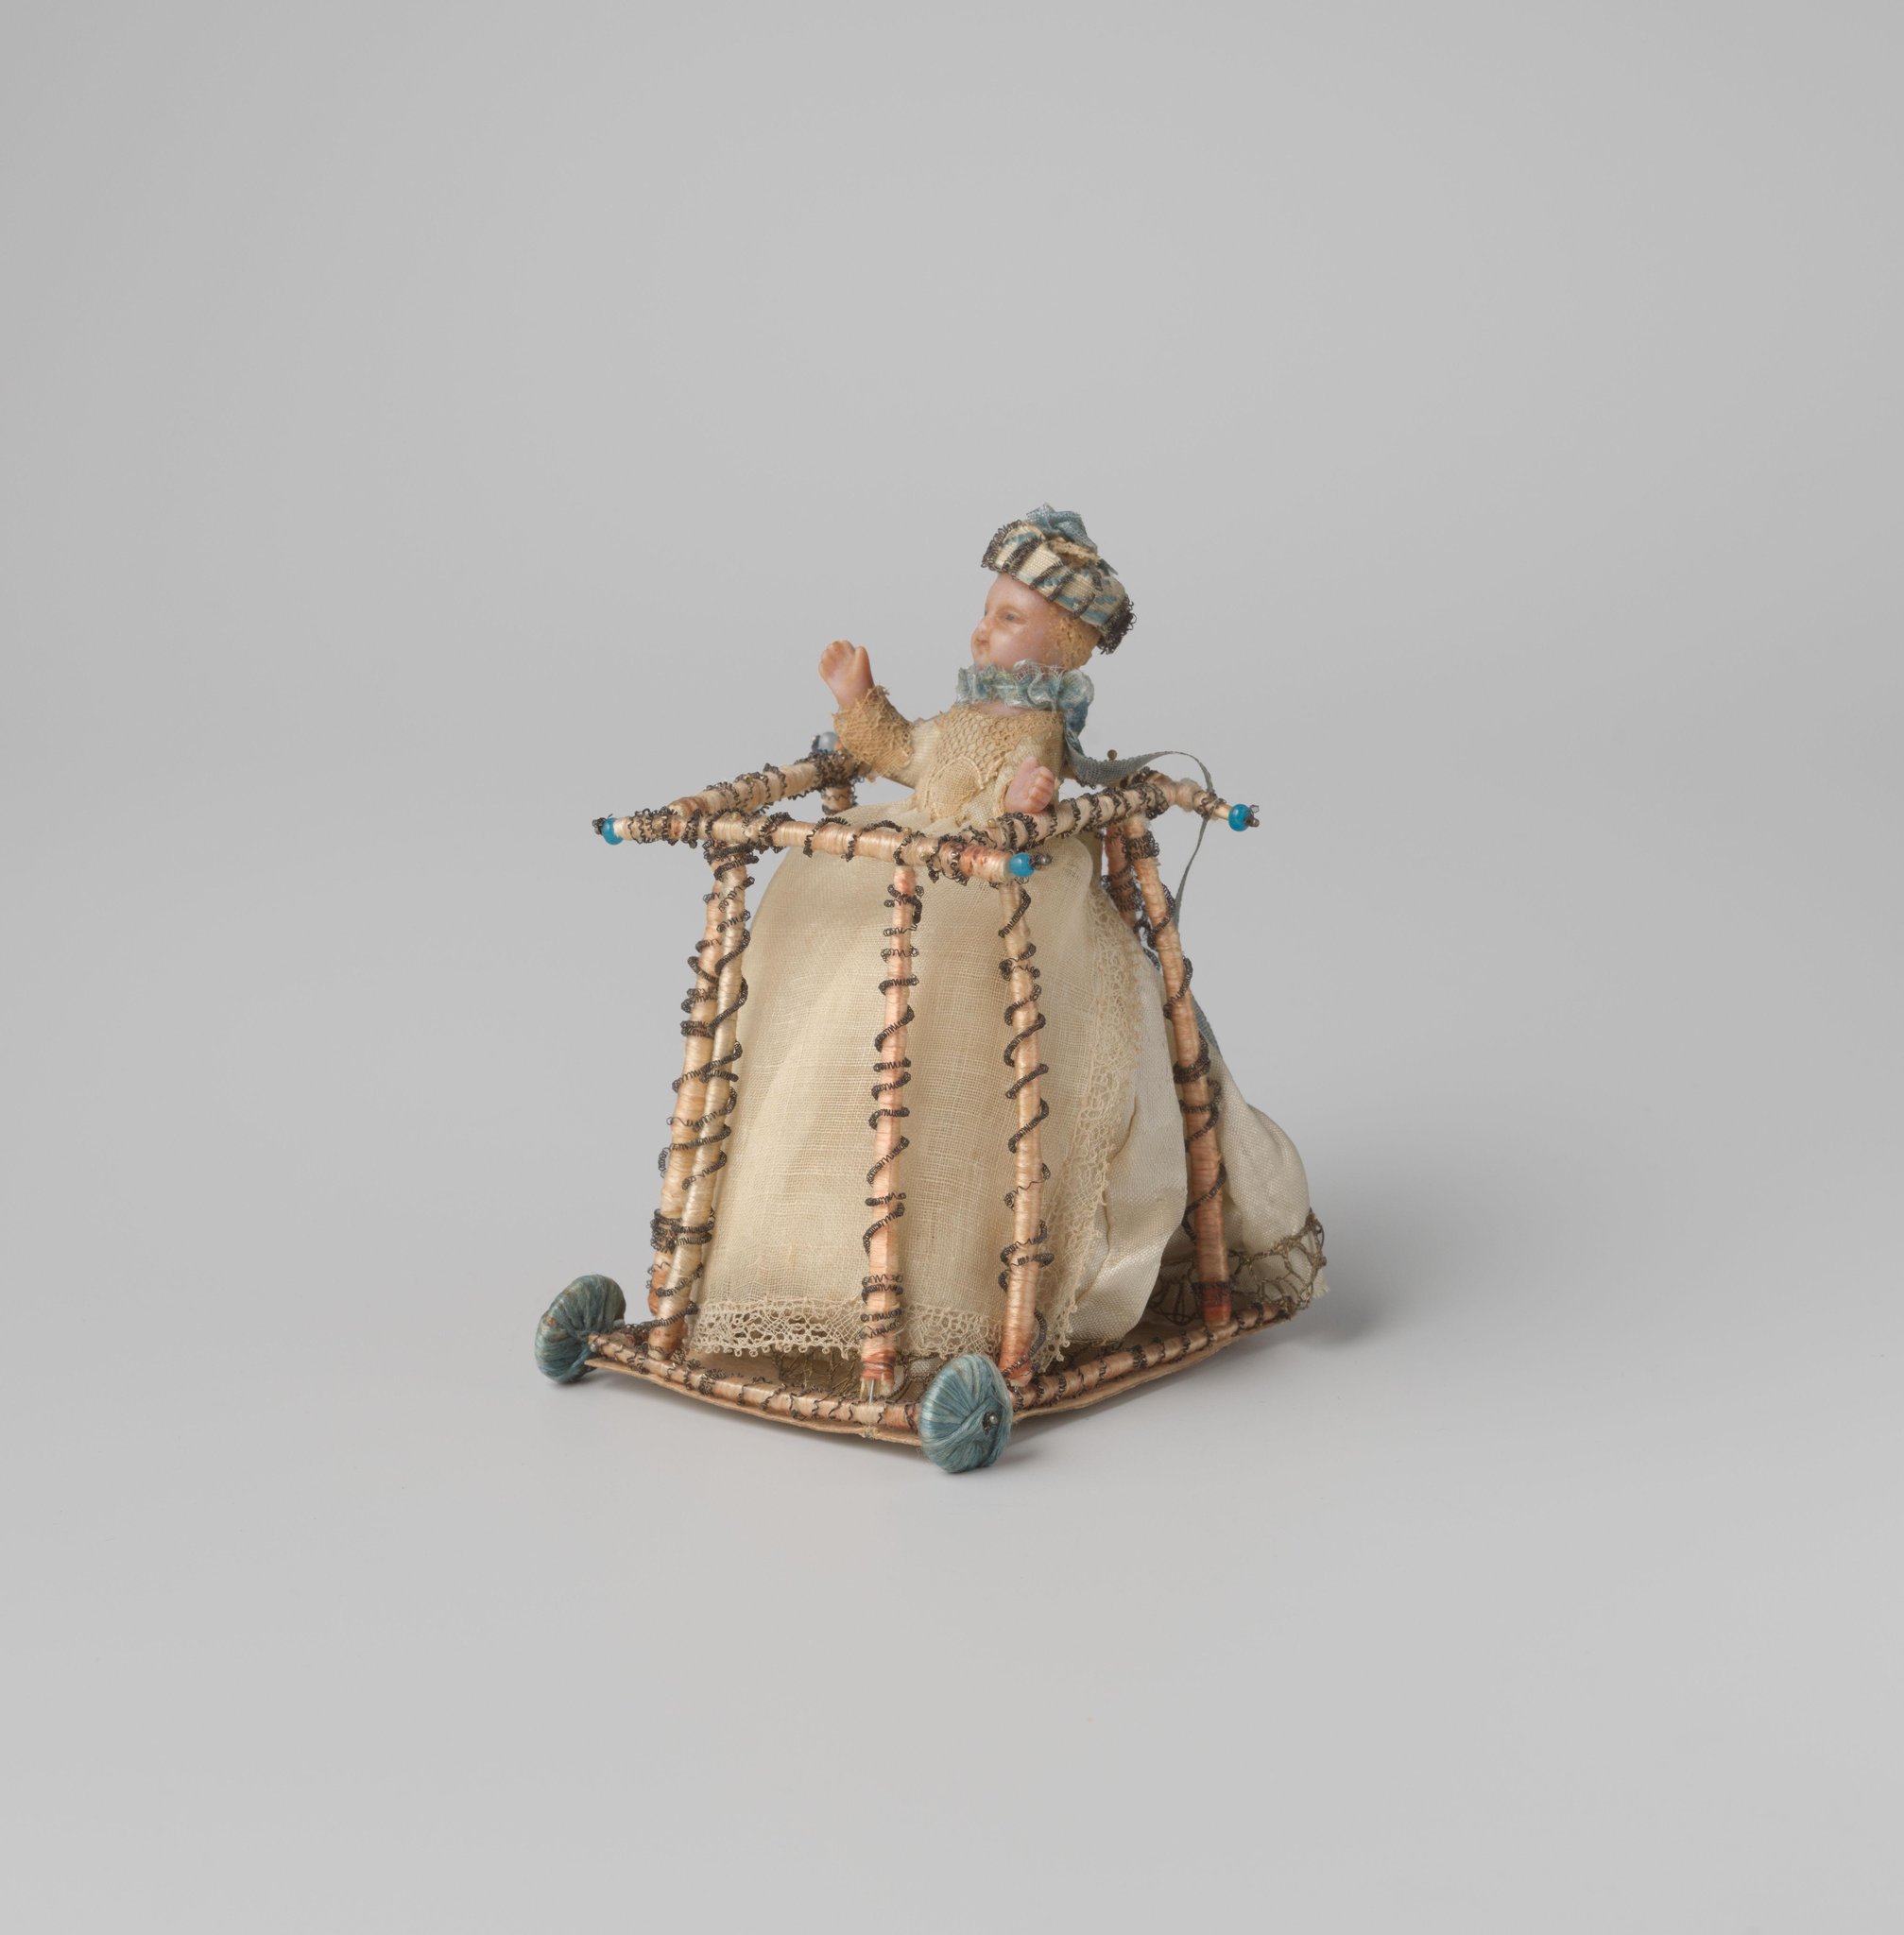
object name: miniature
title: Pop, voorstellende een kind in een looprek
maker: Anonymous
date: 1700-1749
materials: glass, linen, metal, silk, wax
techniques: lace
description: Pop, voorstellende een kind in een looprek, gekleed in een voetlange ongevoerde japon van crèmekleurige zijde, waarover een batisten schort. Hat kind hangt in een looprek op wieltjes.